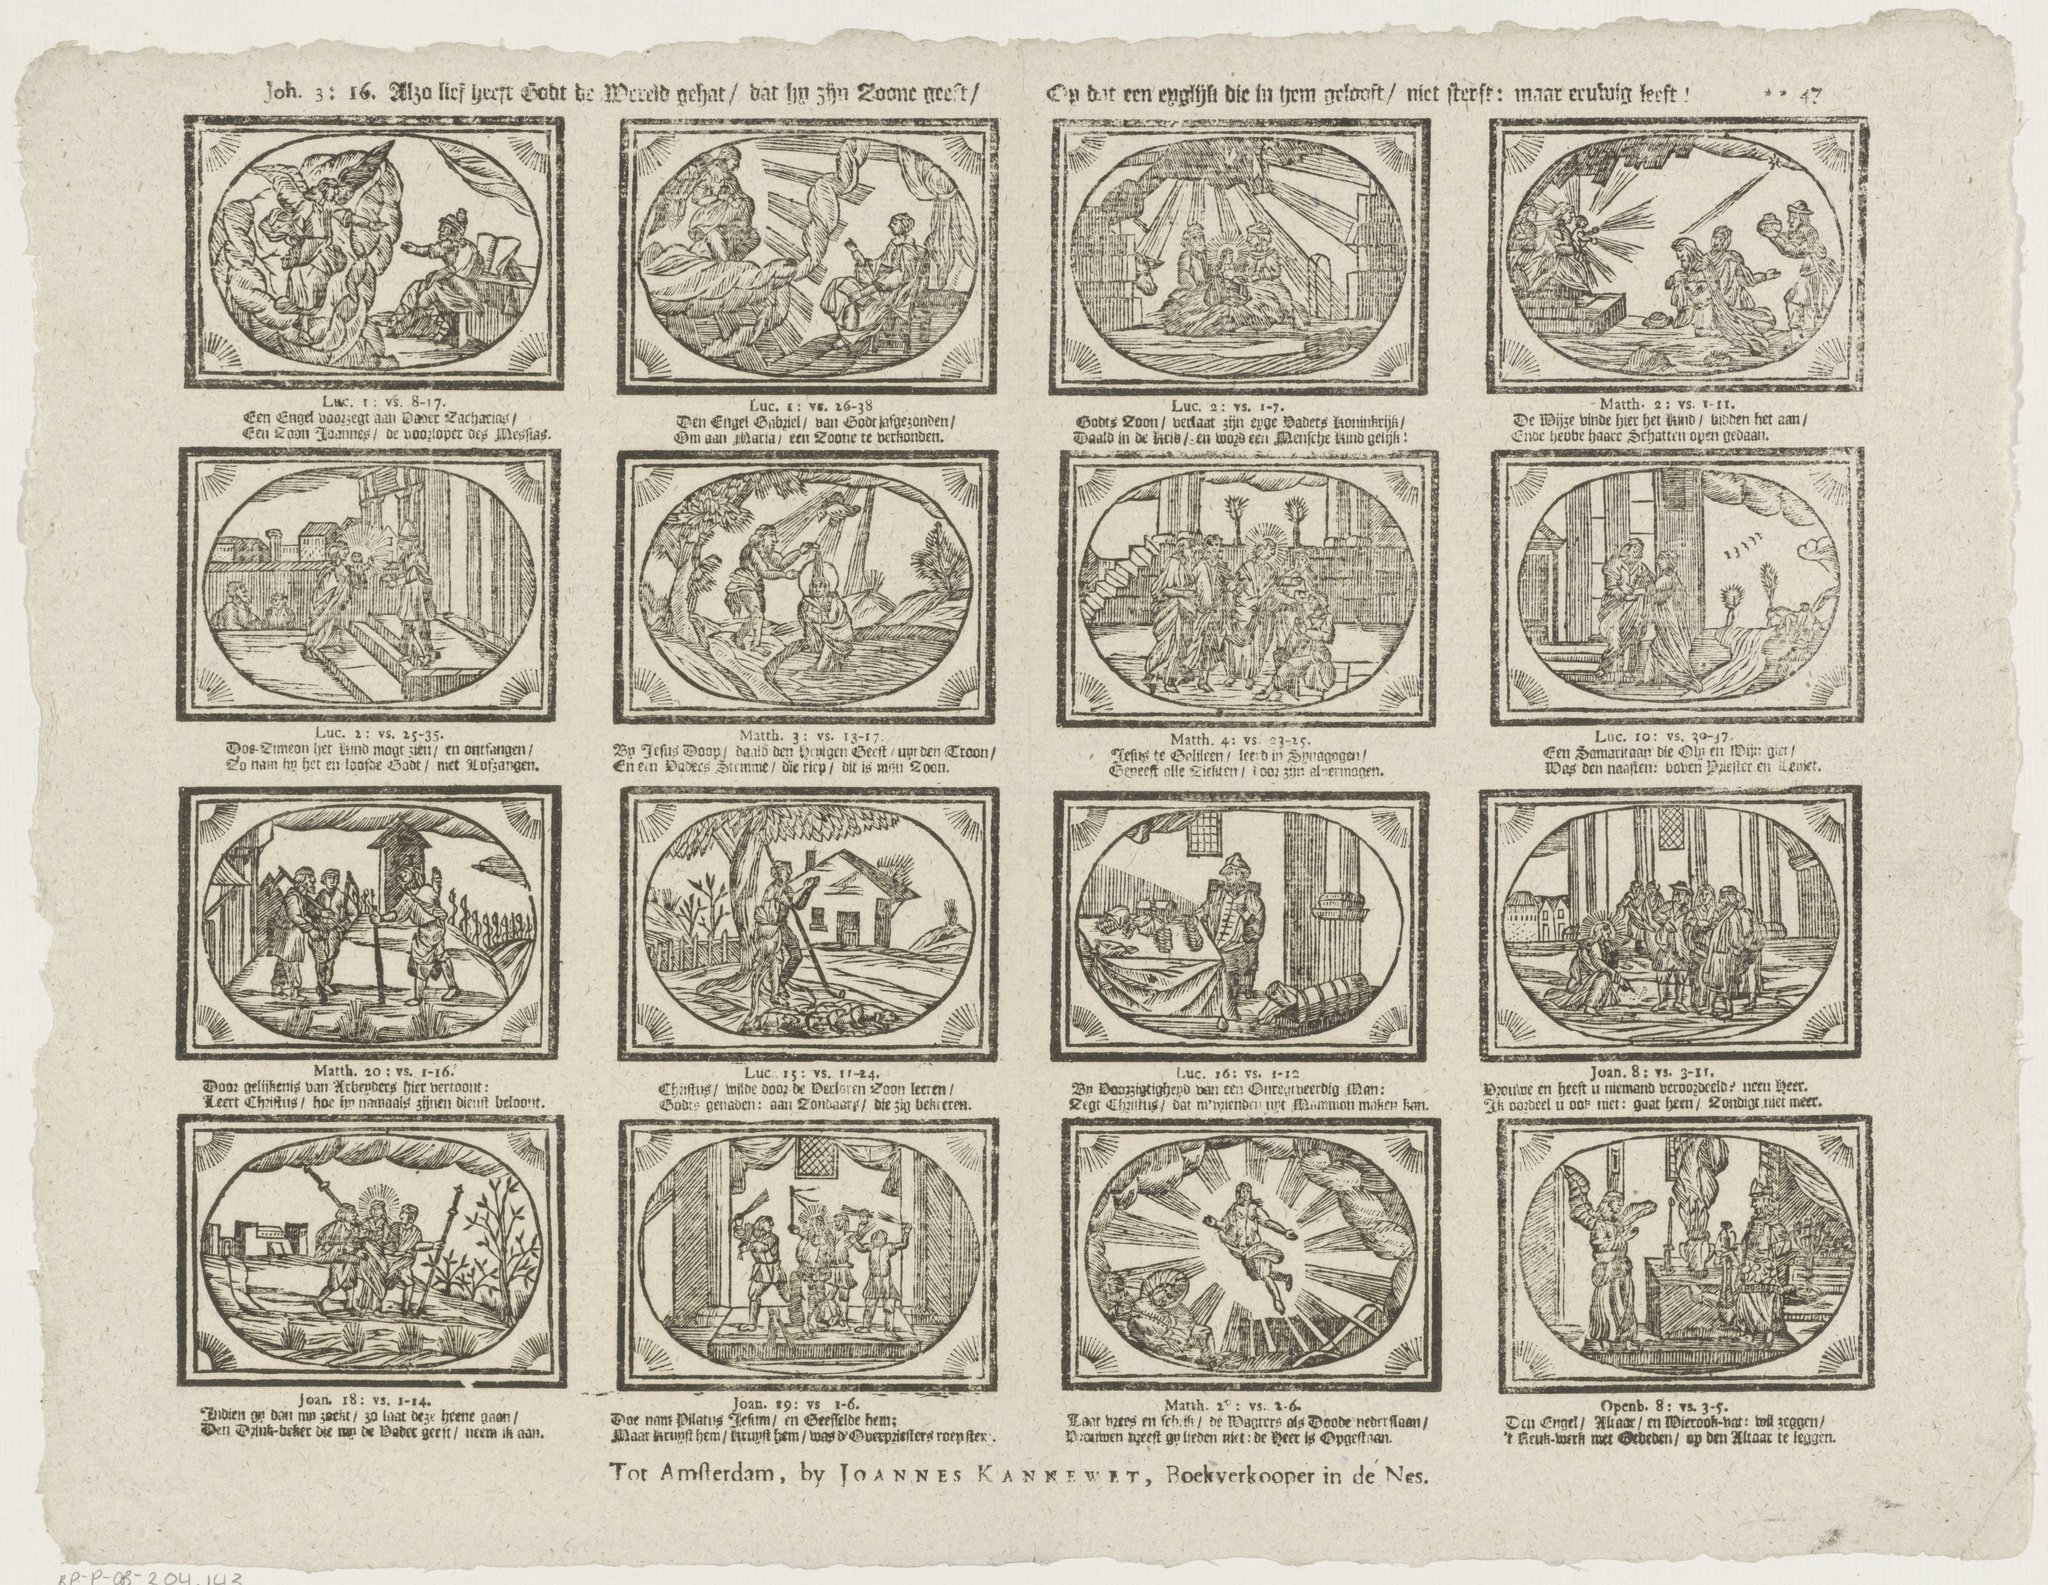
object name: popular print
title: Joh. 3 : 16 Alzo lief heeft God de wereld gehat / dat hy zijn zoone geeft / Op dat een eyglijk die in hem gelooft / niet sterft: maar eeuwig leeft!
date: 1725-1780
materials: paper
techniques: letterpress printing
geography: amsterdam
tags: mary and elisabeth, both pregnant, embracing, new testament, series of scenes from the life of christ, mary, joseph and the new-born christ (nativity)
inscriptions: collector's mark: Lugt 2760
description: Blad met 16 voorstellingen van verhalen uit het Nieuwe Testament, zoals de doop in de Jordaan, de Geseling van Christus en de Visitatie. Onder elke afbeelding een tweeregelig vers en een verwijzing naar de bijbehorende Bijbeltekst. Genummerd rechtsboven: **47.